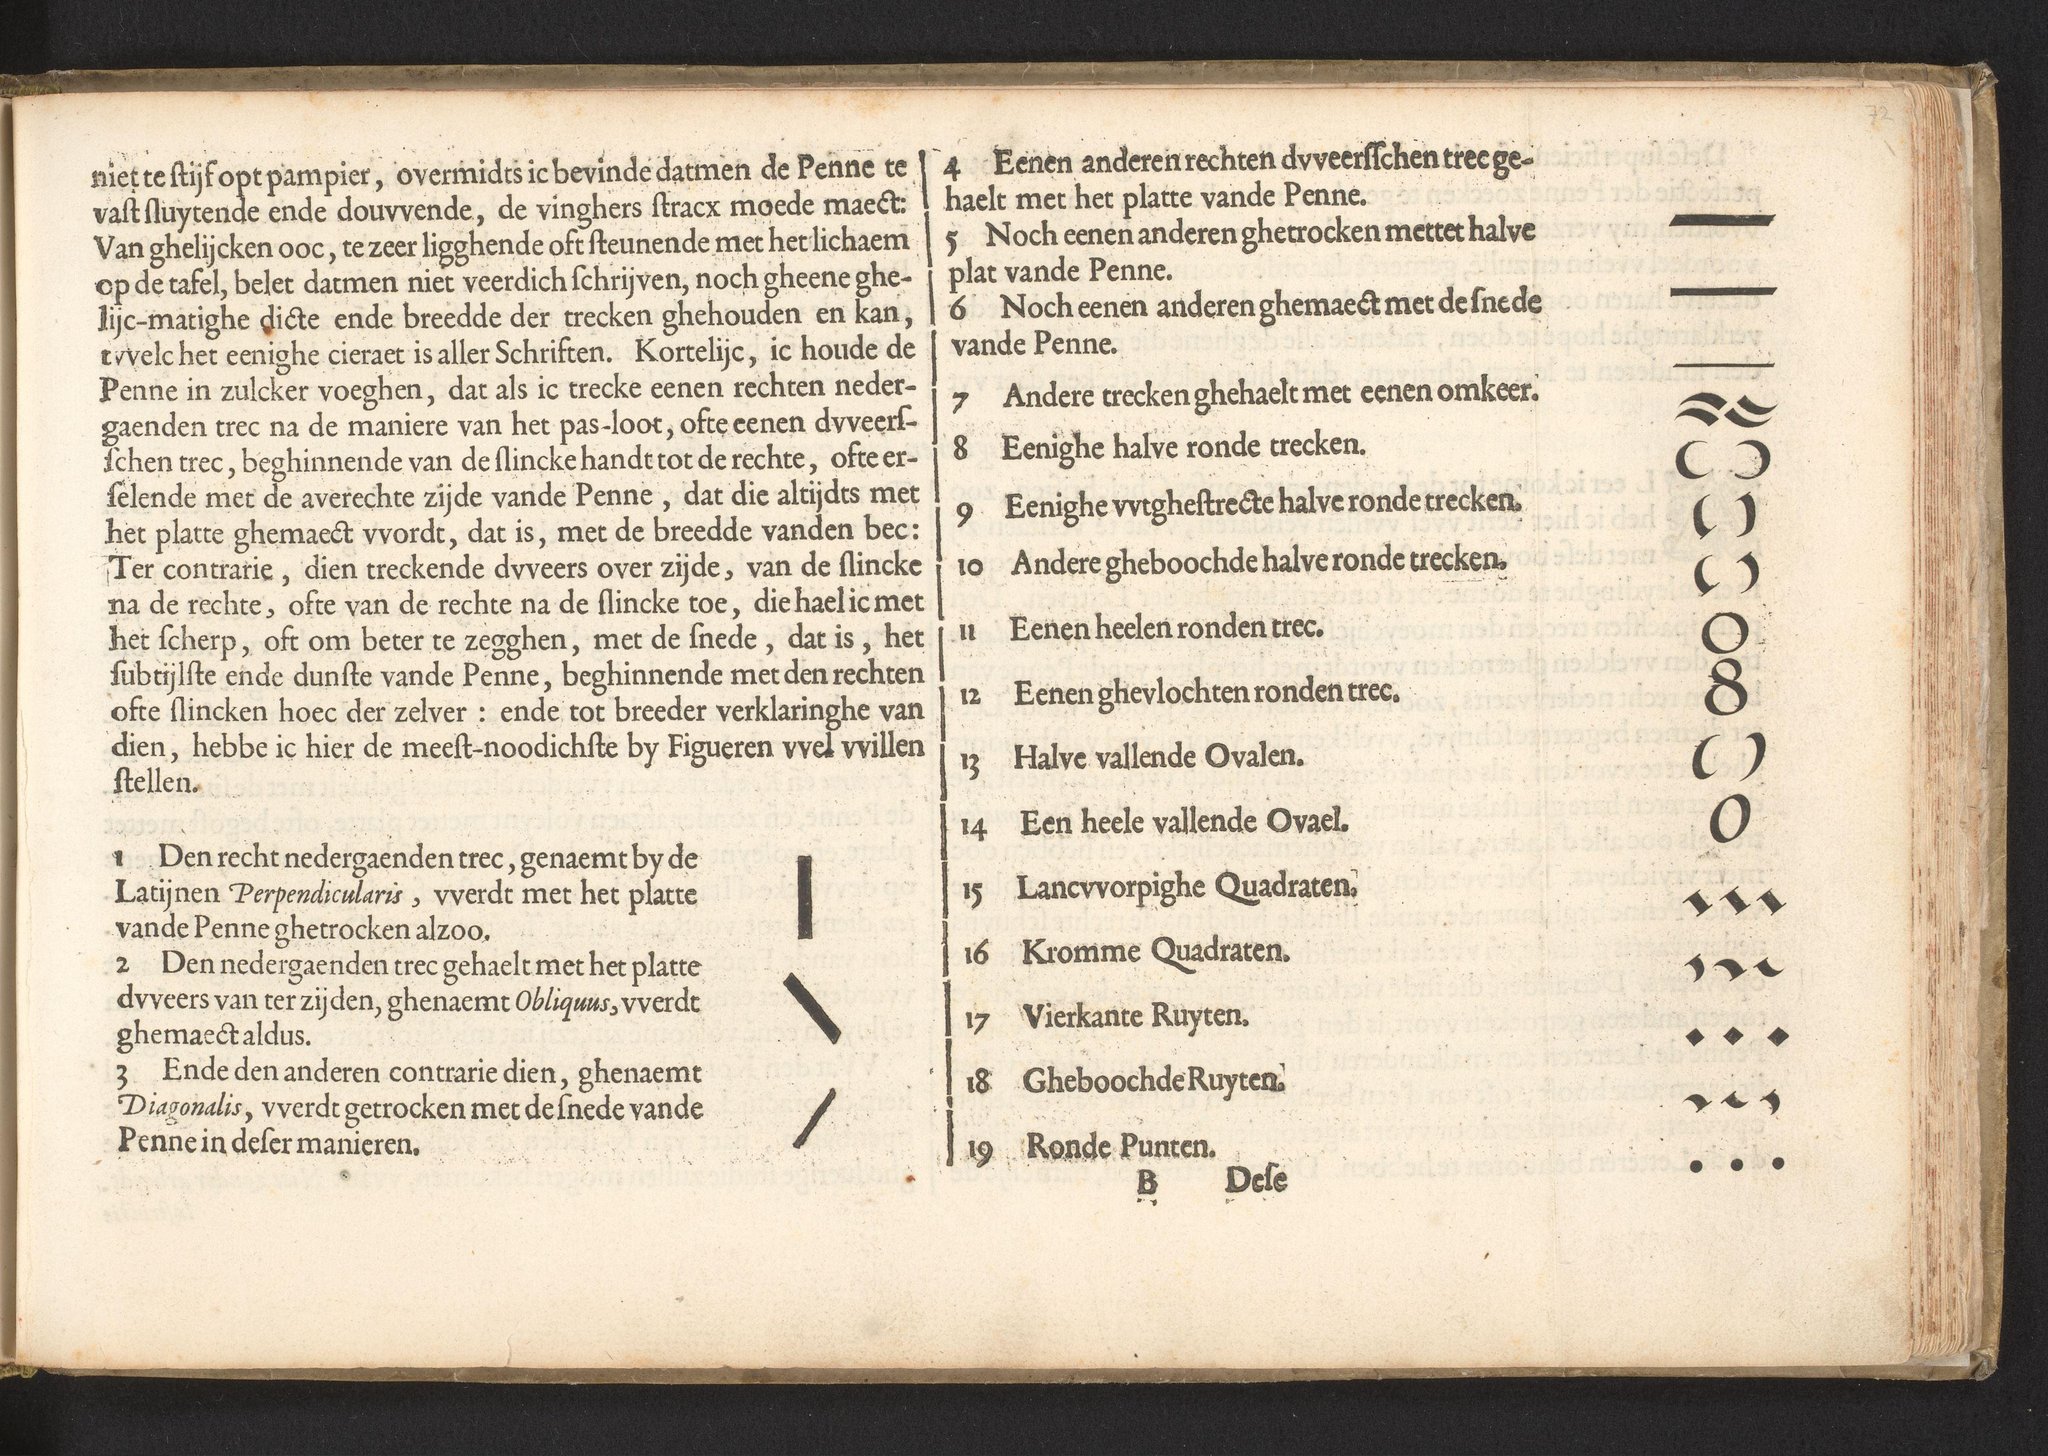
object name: album leaf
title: Fondement-Boeck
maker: jan van de velde (i)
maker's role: painter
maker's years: 1568-1623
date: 1605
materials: paper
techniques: letterpress printing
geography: rotterdam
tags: calligraphy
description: Folio B1r. Tekstblad met het vervolg van de instructie over hoe de rietpen vastgehouden moet worden. Daarbij enkele voorbeelden. Het tekstblad maakt deel uit van een album.